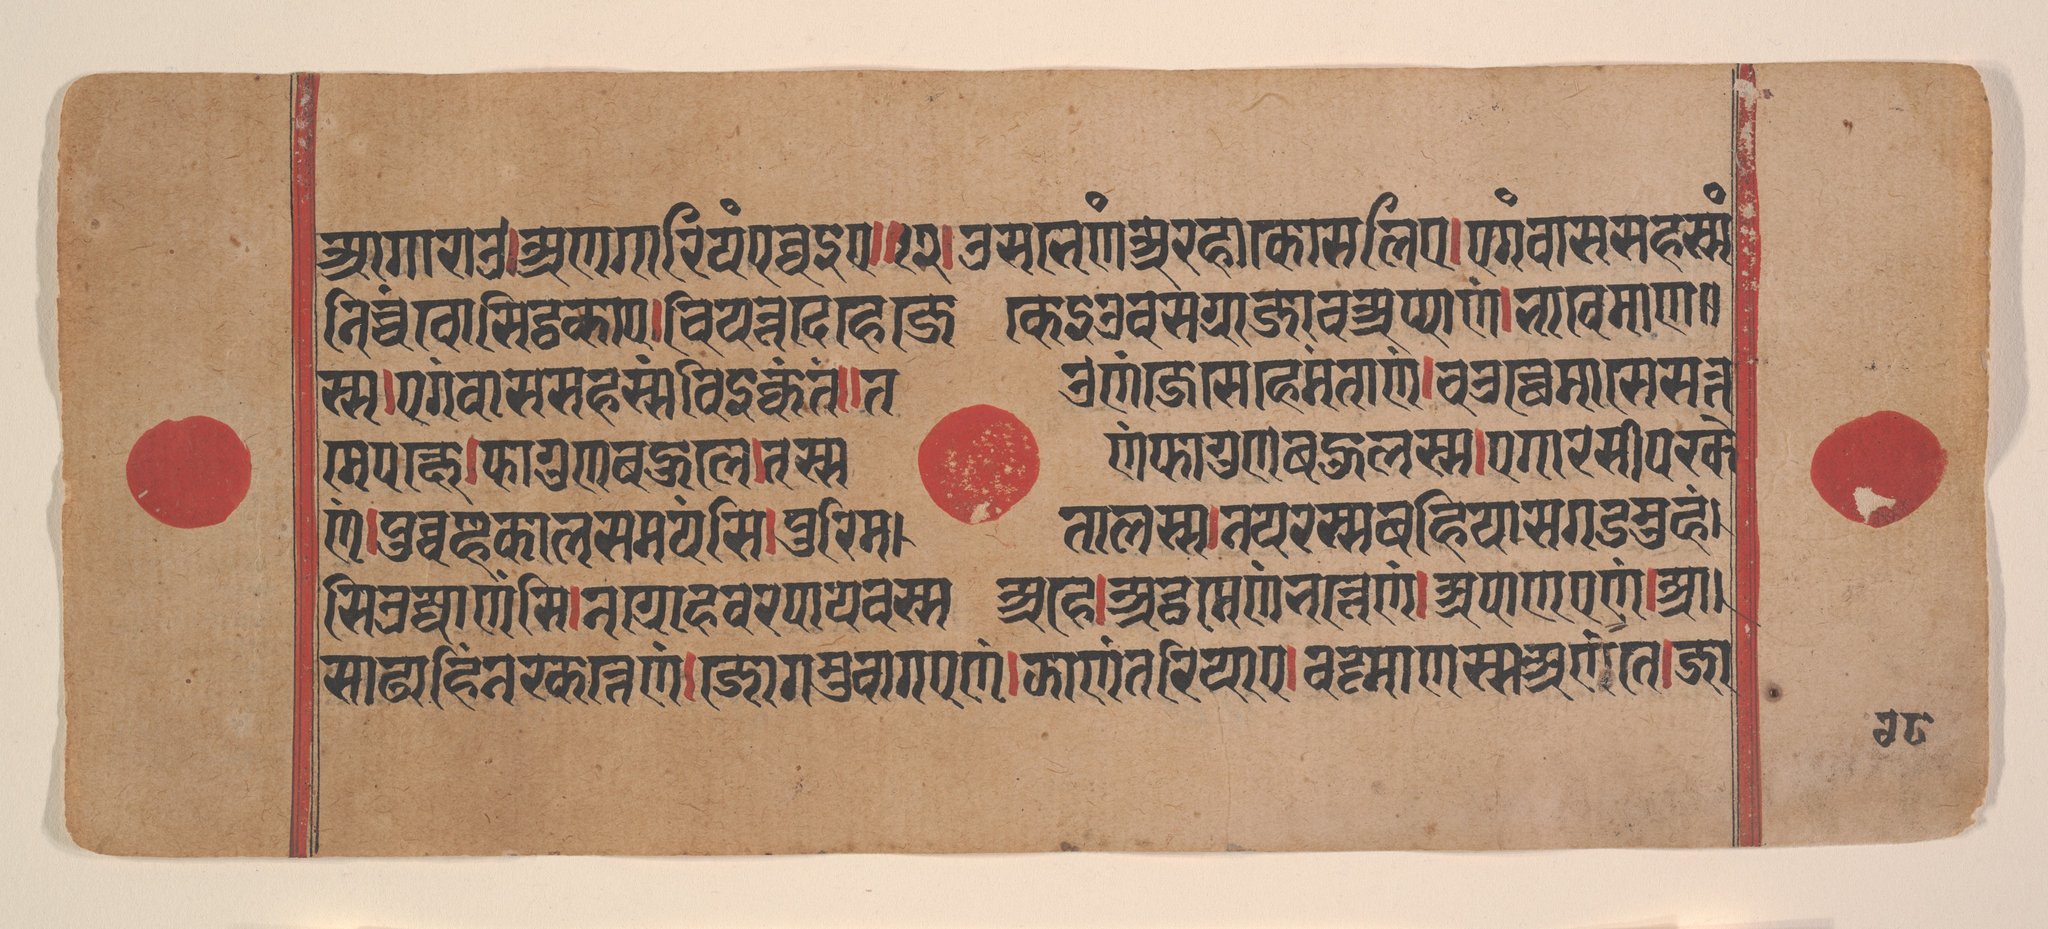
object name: folio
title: Page from a Dispersed Kalpa Sutra (Jain Book of Rituals)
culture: indian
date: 1401-1500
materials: gold, ink, paper, watercolor